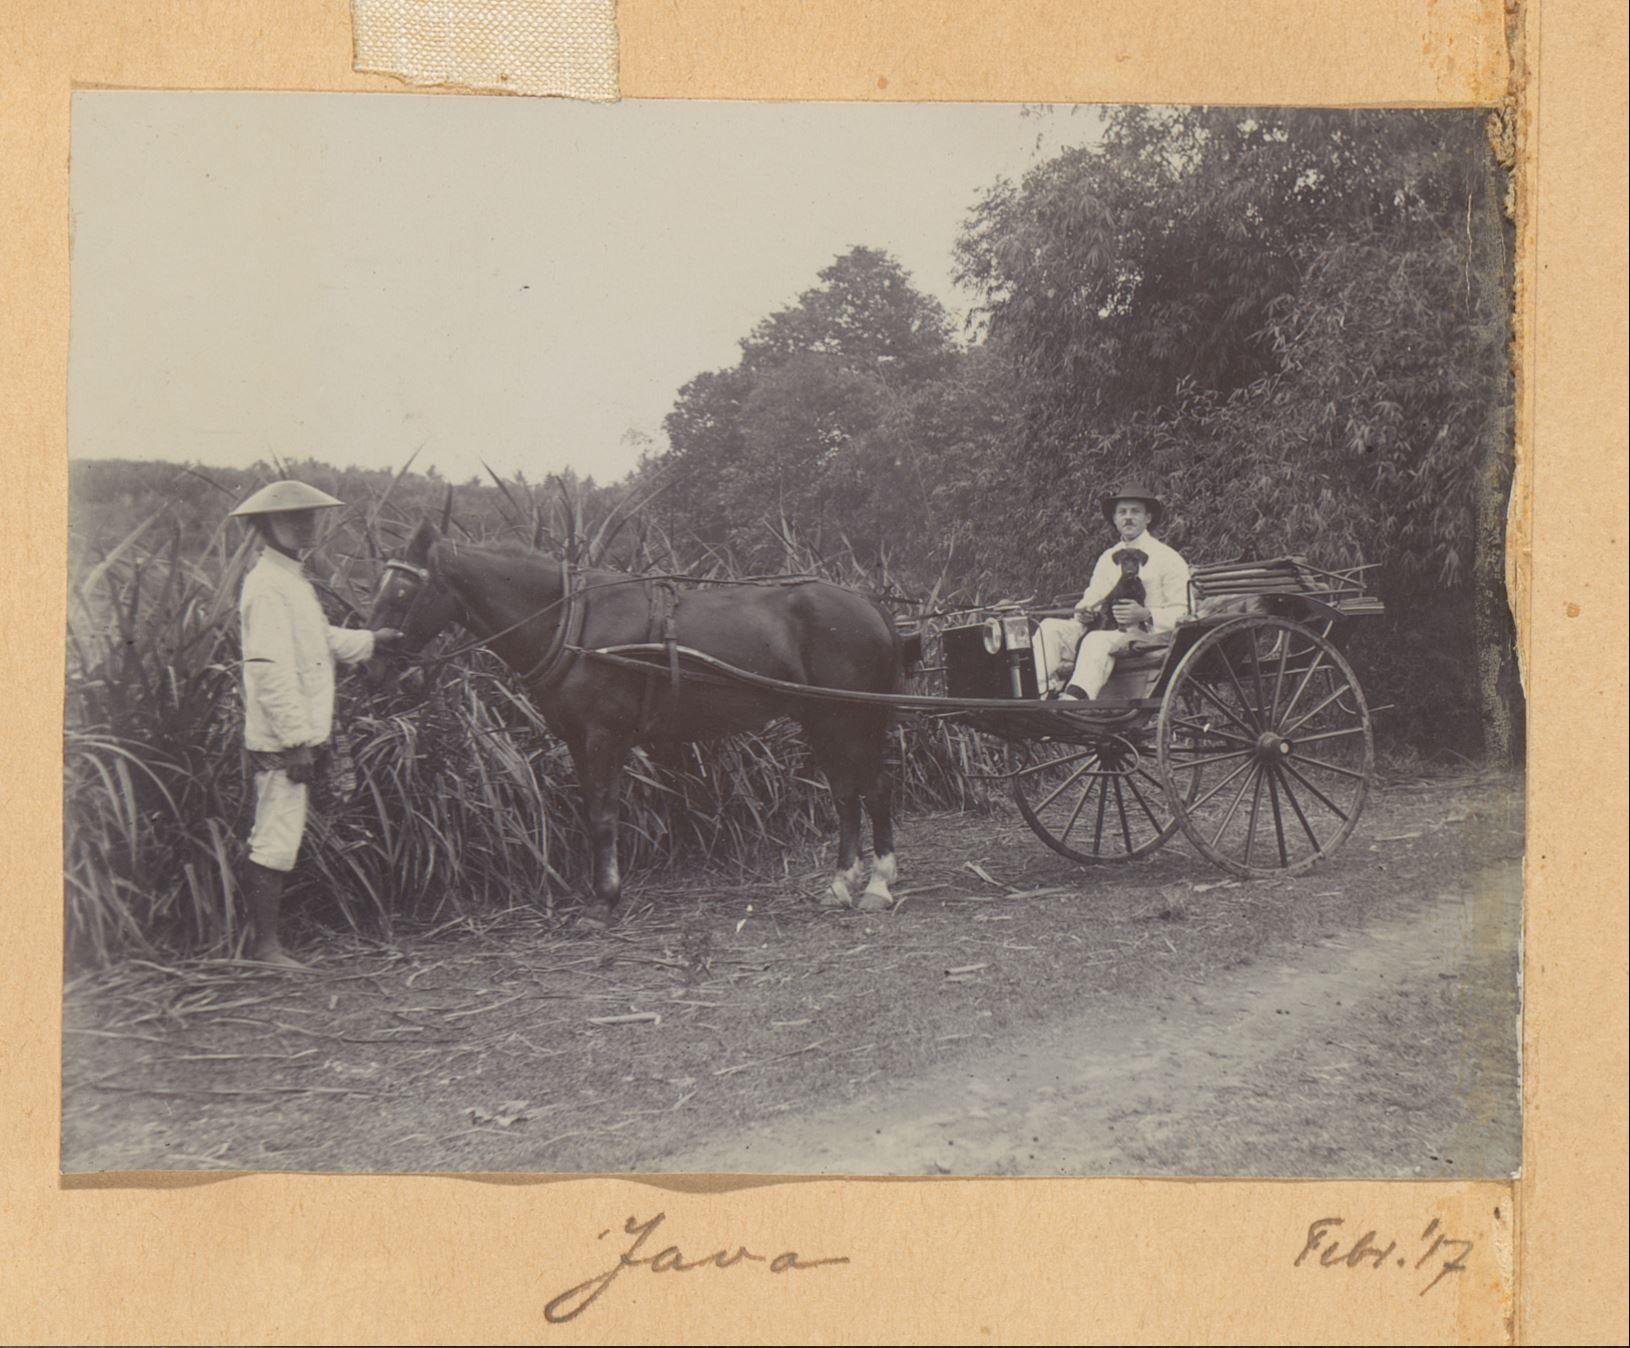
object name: photograph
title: Europese man met hond en een Indonesische man bij een rijtuig op Java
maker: Anonymous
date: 1902-1917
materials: photographic support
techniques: gelatin silver print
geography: java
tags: two-wheeled, animal-drawn vehicle, java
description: Onderdeel van Familiealbum met foto's van een familie in de voormalige kolonie Nederlands-Indië en van een suikerfabriek in Purworejo.